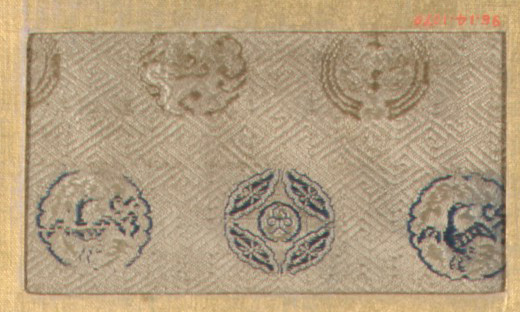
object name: piece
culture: japanese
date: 1701-1900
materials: silk